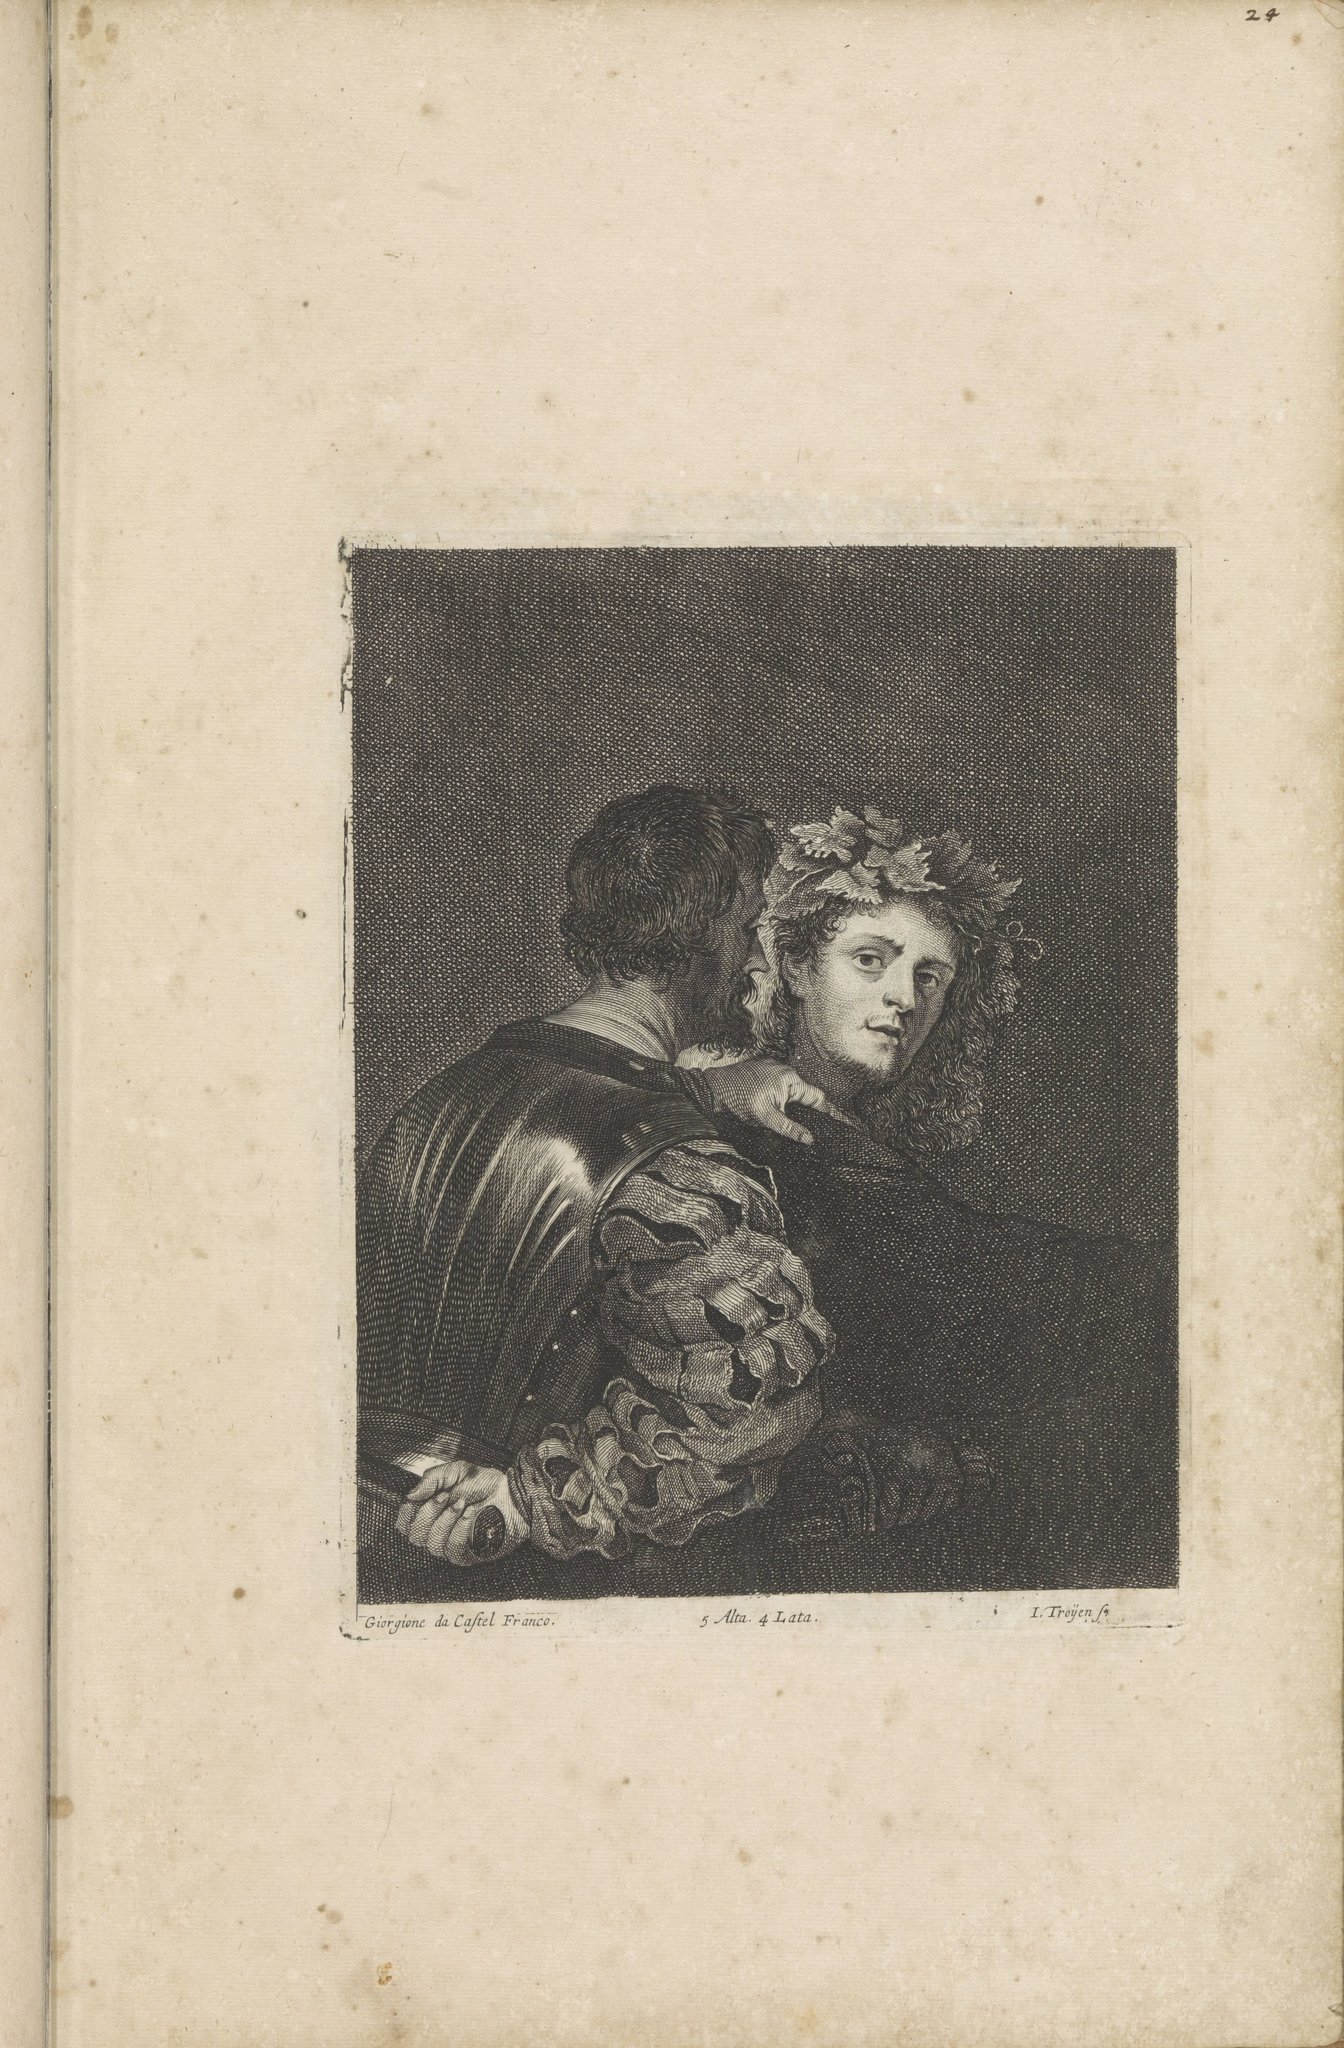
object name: print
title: De moordenaar (Il Bravo)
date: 1660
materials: paper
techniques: engraving, etching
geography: brussels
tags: murderer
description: Prent naar het schilderij van (toegeschreven aan) Tititaan dat zich in de collectie van het Kunsthistorisches Museum te Wenen bevindt (inventarisnummer GG_64). David Teniers heeft waarschijnlijk van alle schilderijen uit de collectie van Leopold Willem van Oostenrijk een olieverfstudie op doek of paneel vervaardigd (zgn. pasticcio), die als voorbeeld voor de prentmakers diende. Het is niet altijd duidelijk of de pasticci door hem zijn gemaakt of door zijn atelier. Niet alle pasticci zijn overgeleverd.